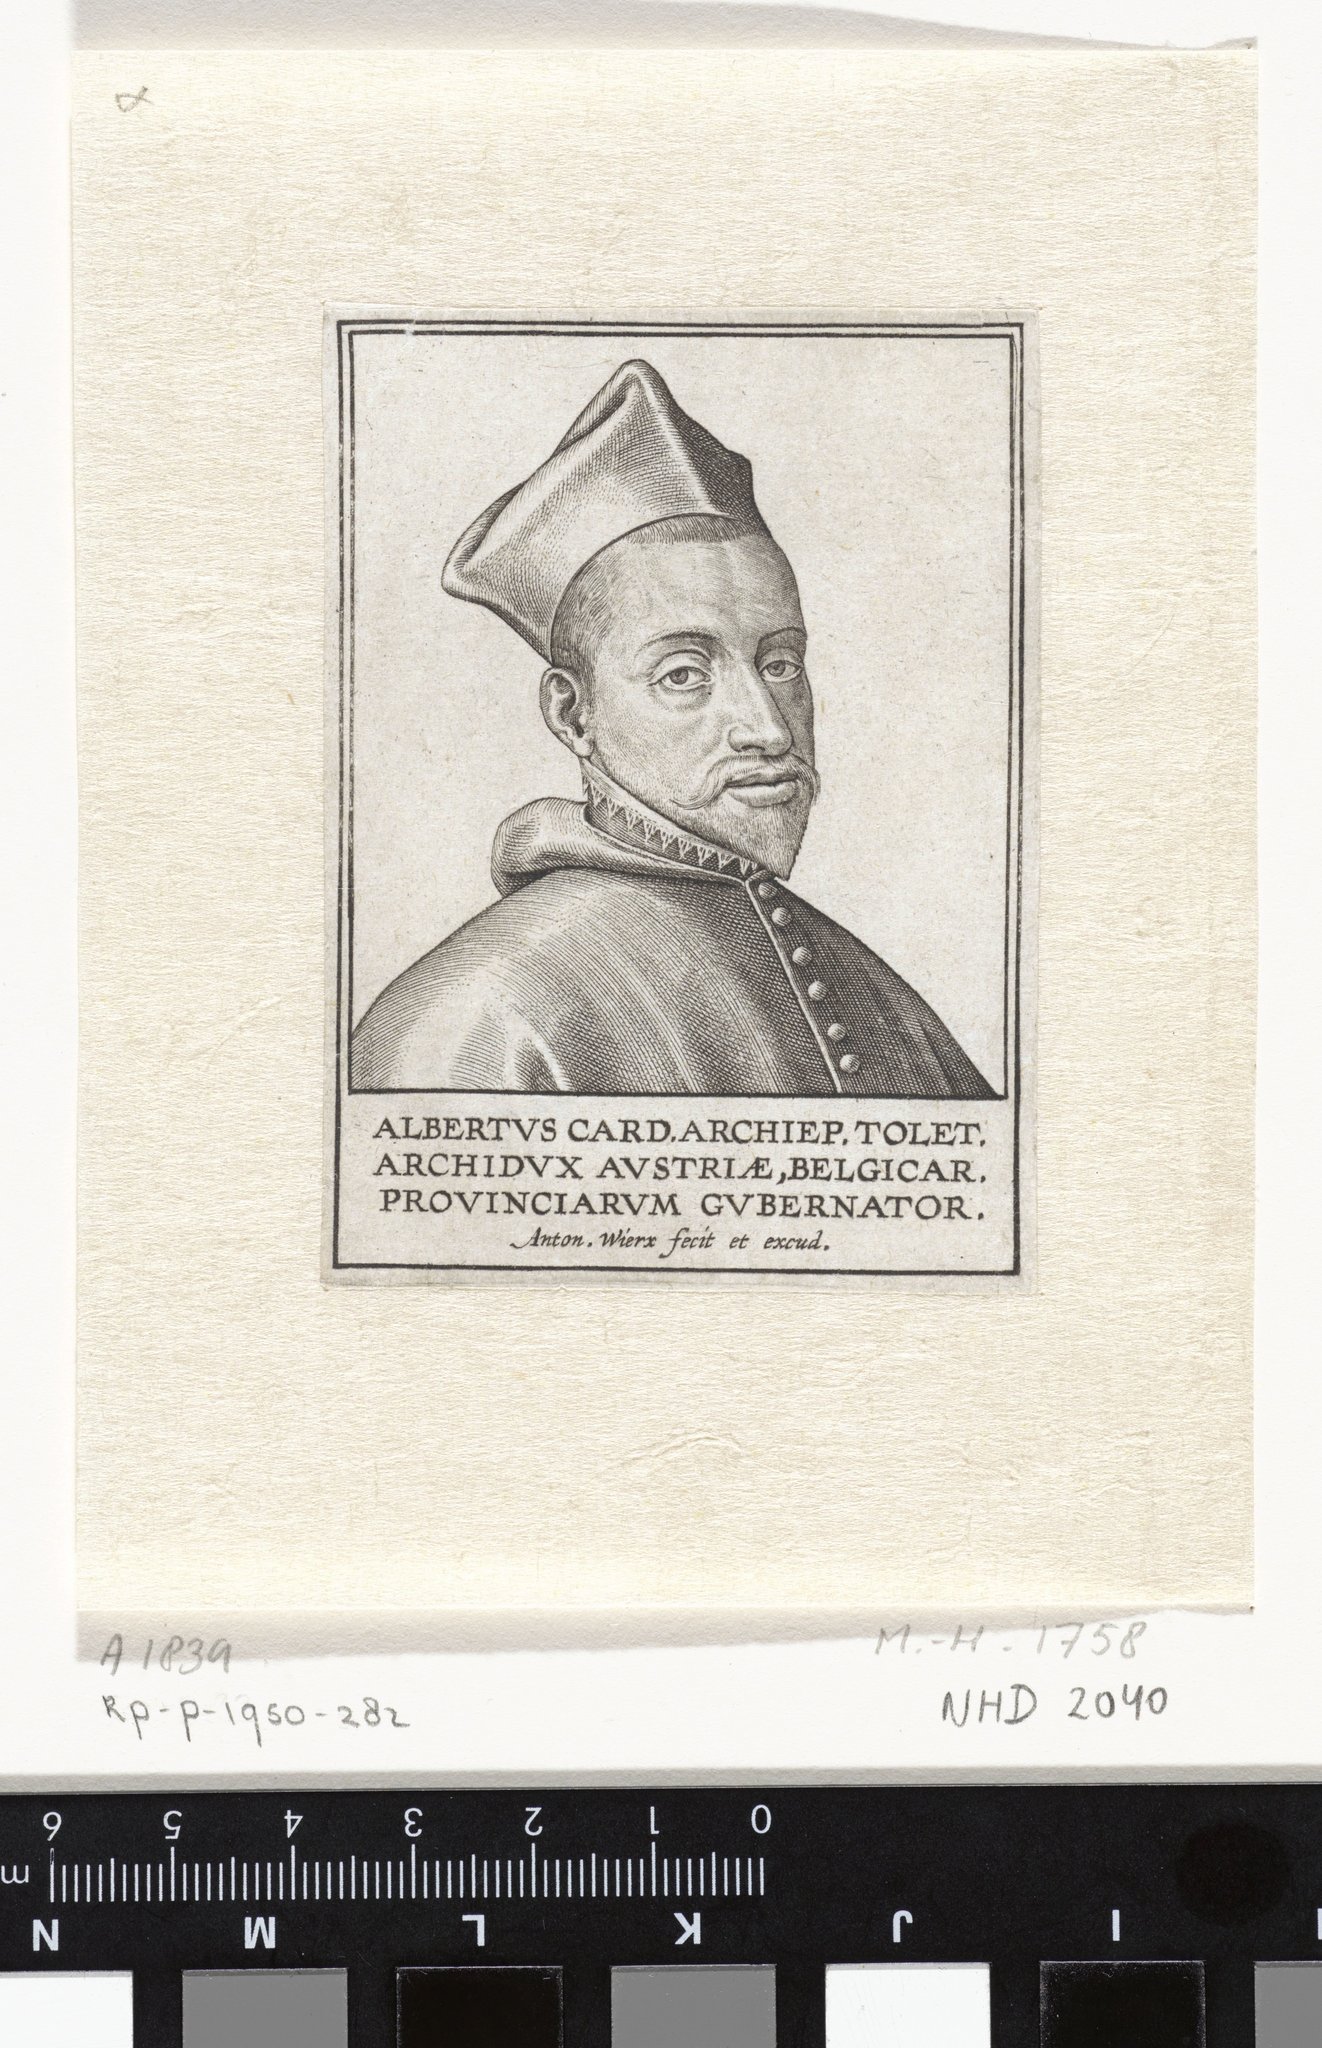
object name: print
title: Portret van Albrecht, aartshertog van Oostenrijk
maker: antonie wierix (ii)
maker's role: draughtsman, print maker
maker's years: 1555-1604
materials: paper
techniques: engraving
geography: antwerp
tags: brussels, albrecht aartshertog van oostenrijk, head-gear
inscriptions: collector's mark: Lugt 2228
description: Busteportret van Albrecht, aartshertog van Oostenrijk. Hij draagt een biretta. In de marge een drieregelig onderschrift in het Latijn.